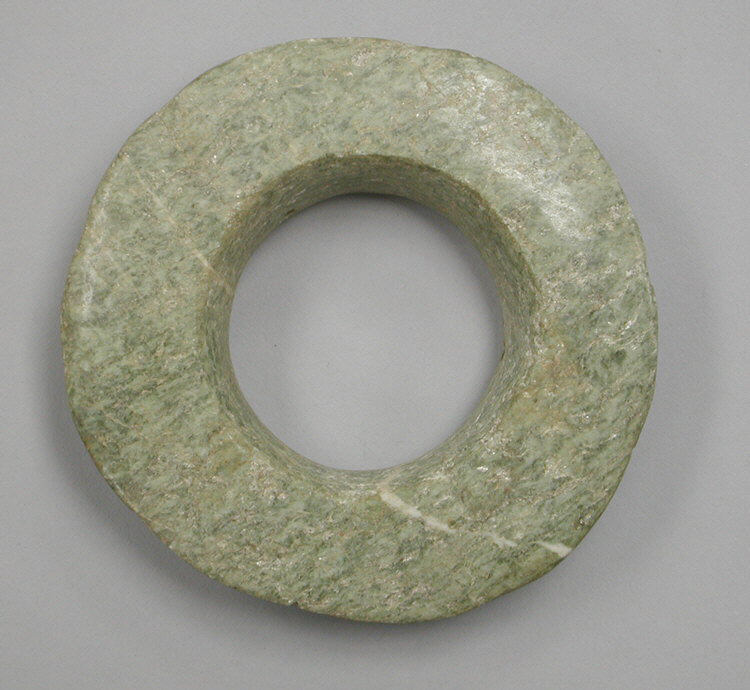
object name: earflare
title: Stone Earflare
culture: mexican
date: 1501-1600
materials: stone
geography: mexico